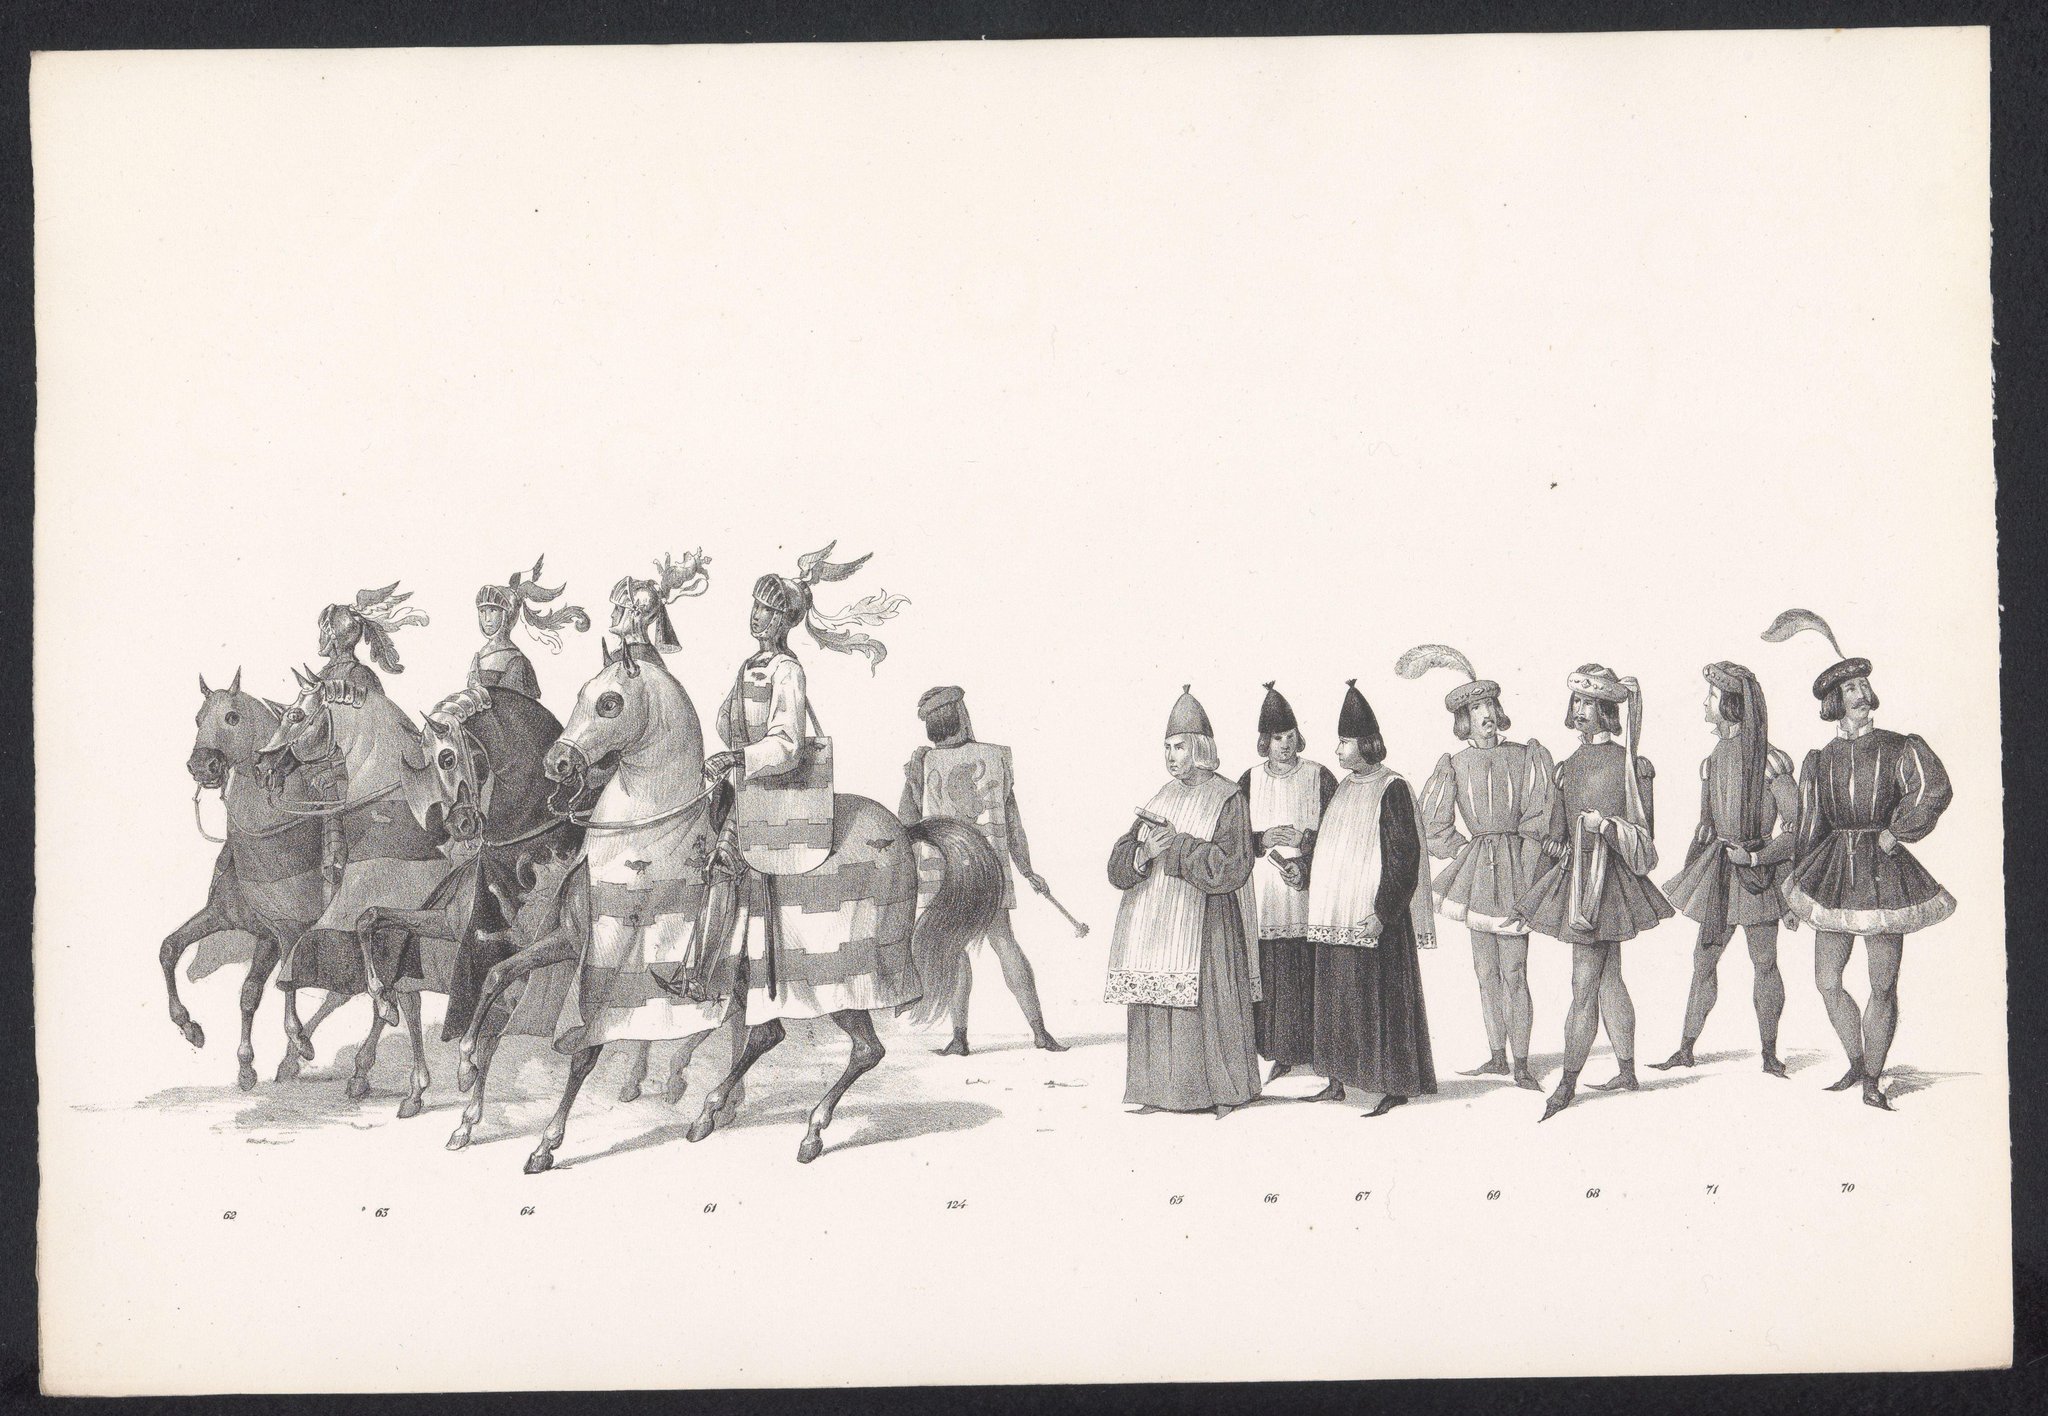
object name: print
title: Maskerade door studenten van de Leidse Hogeschool, 1840 (plaat 10)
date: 1840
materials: paper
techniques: lithograph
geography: leiden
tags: jan van beieren, students' pageant, costumes used in pageants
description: Historische gekostumeerde optocht van de studenten van de Hogeschool van Leiden op 8 februari 1840. De optocht verbeeldt de intocht van hertog Jan van Beieren te Leiden op 18 augustus 1420. Tiende plaat in een serie van negentien ongenummerde platen, met de groepen genummerd 62-70.